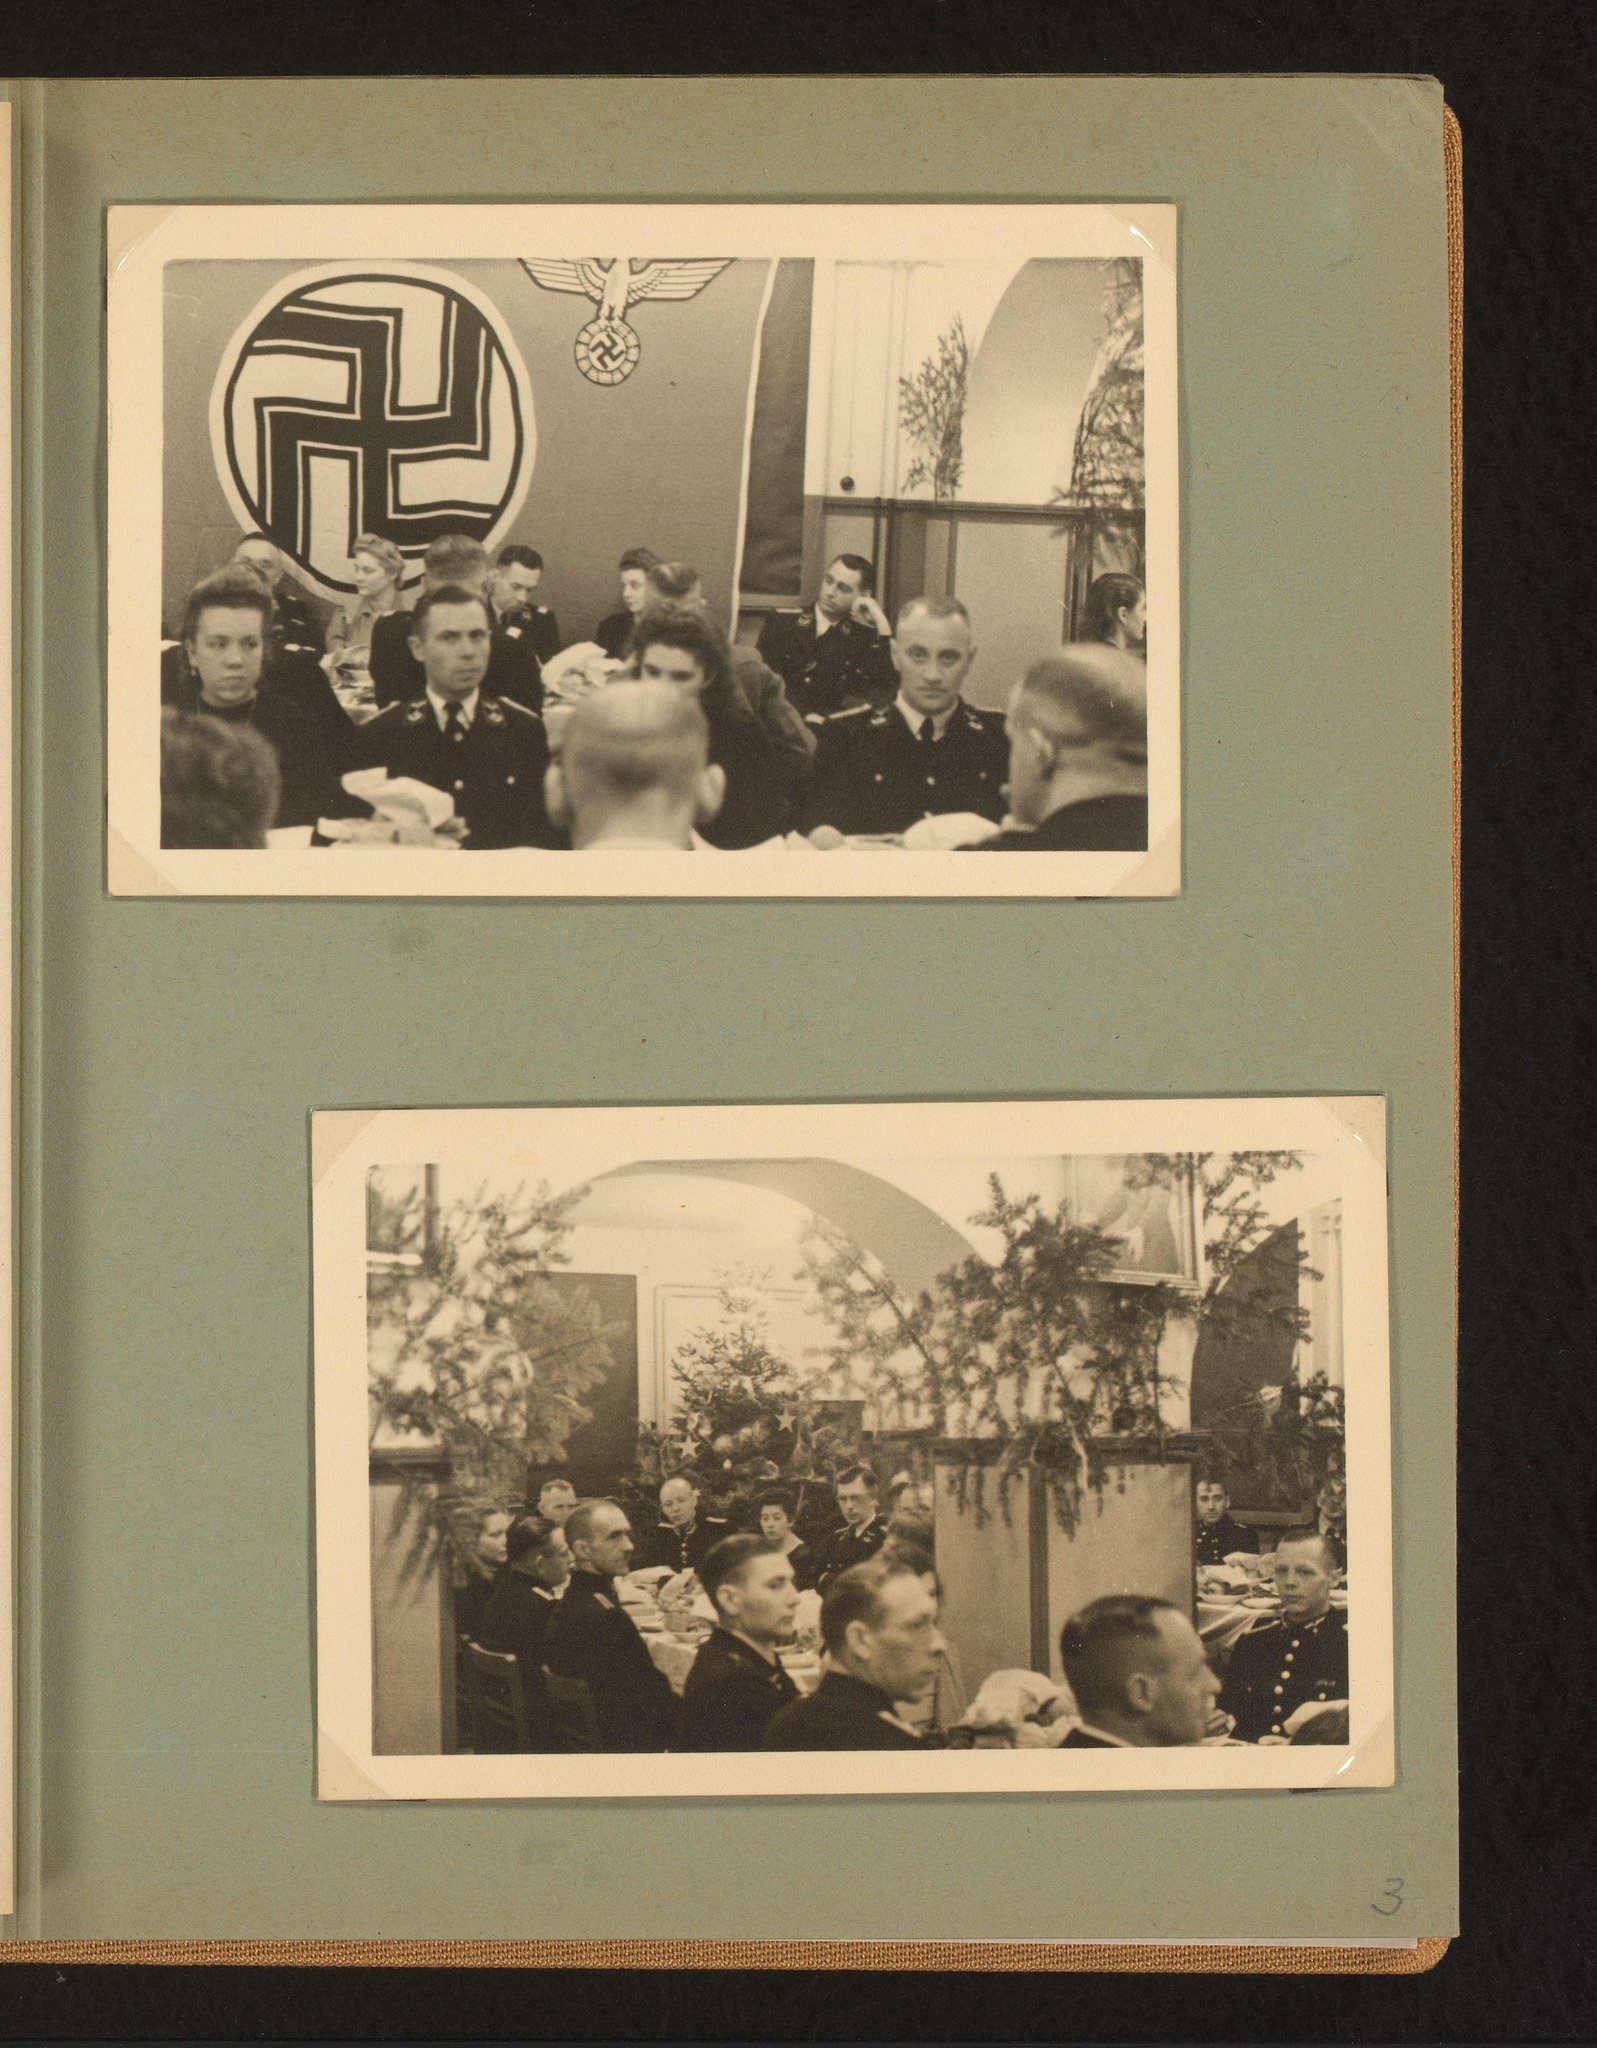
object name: album leaf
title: Kerstfeest bij de Reichsbahn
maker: Anonymous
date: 1943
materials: cardboard, photographic support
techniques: gelatin silver print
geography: utrecht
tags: christmas (non-liturgical celebration), utrecht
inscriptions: inscription: ‘Weihnachtsfeier (Kameradschaftsabend) am 17.12.1943 beim Bbo Utrecht’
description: Albumblad met twee foto's van de viering van het kerstfeest bij de Deutsche Reichsbahn op 17 december 1943. Foto's van de tafels met genodigden. Beide foto's hebben achter aan de muur de hakenkruisvlag met adelaar en het symbool van de spoorwegen. Waarschijnlijk in de Stadsschouwburg te Utrecht. Onderdeel van het fotoalbum Deutsche Reichsbahn, 1943-1944.